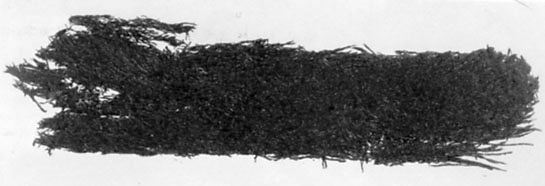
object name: fragment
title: Textile Fragment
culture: swiss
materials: textile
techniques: weave